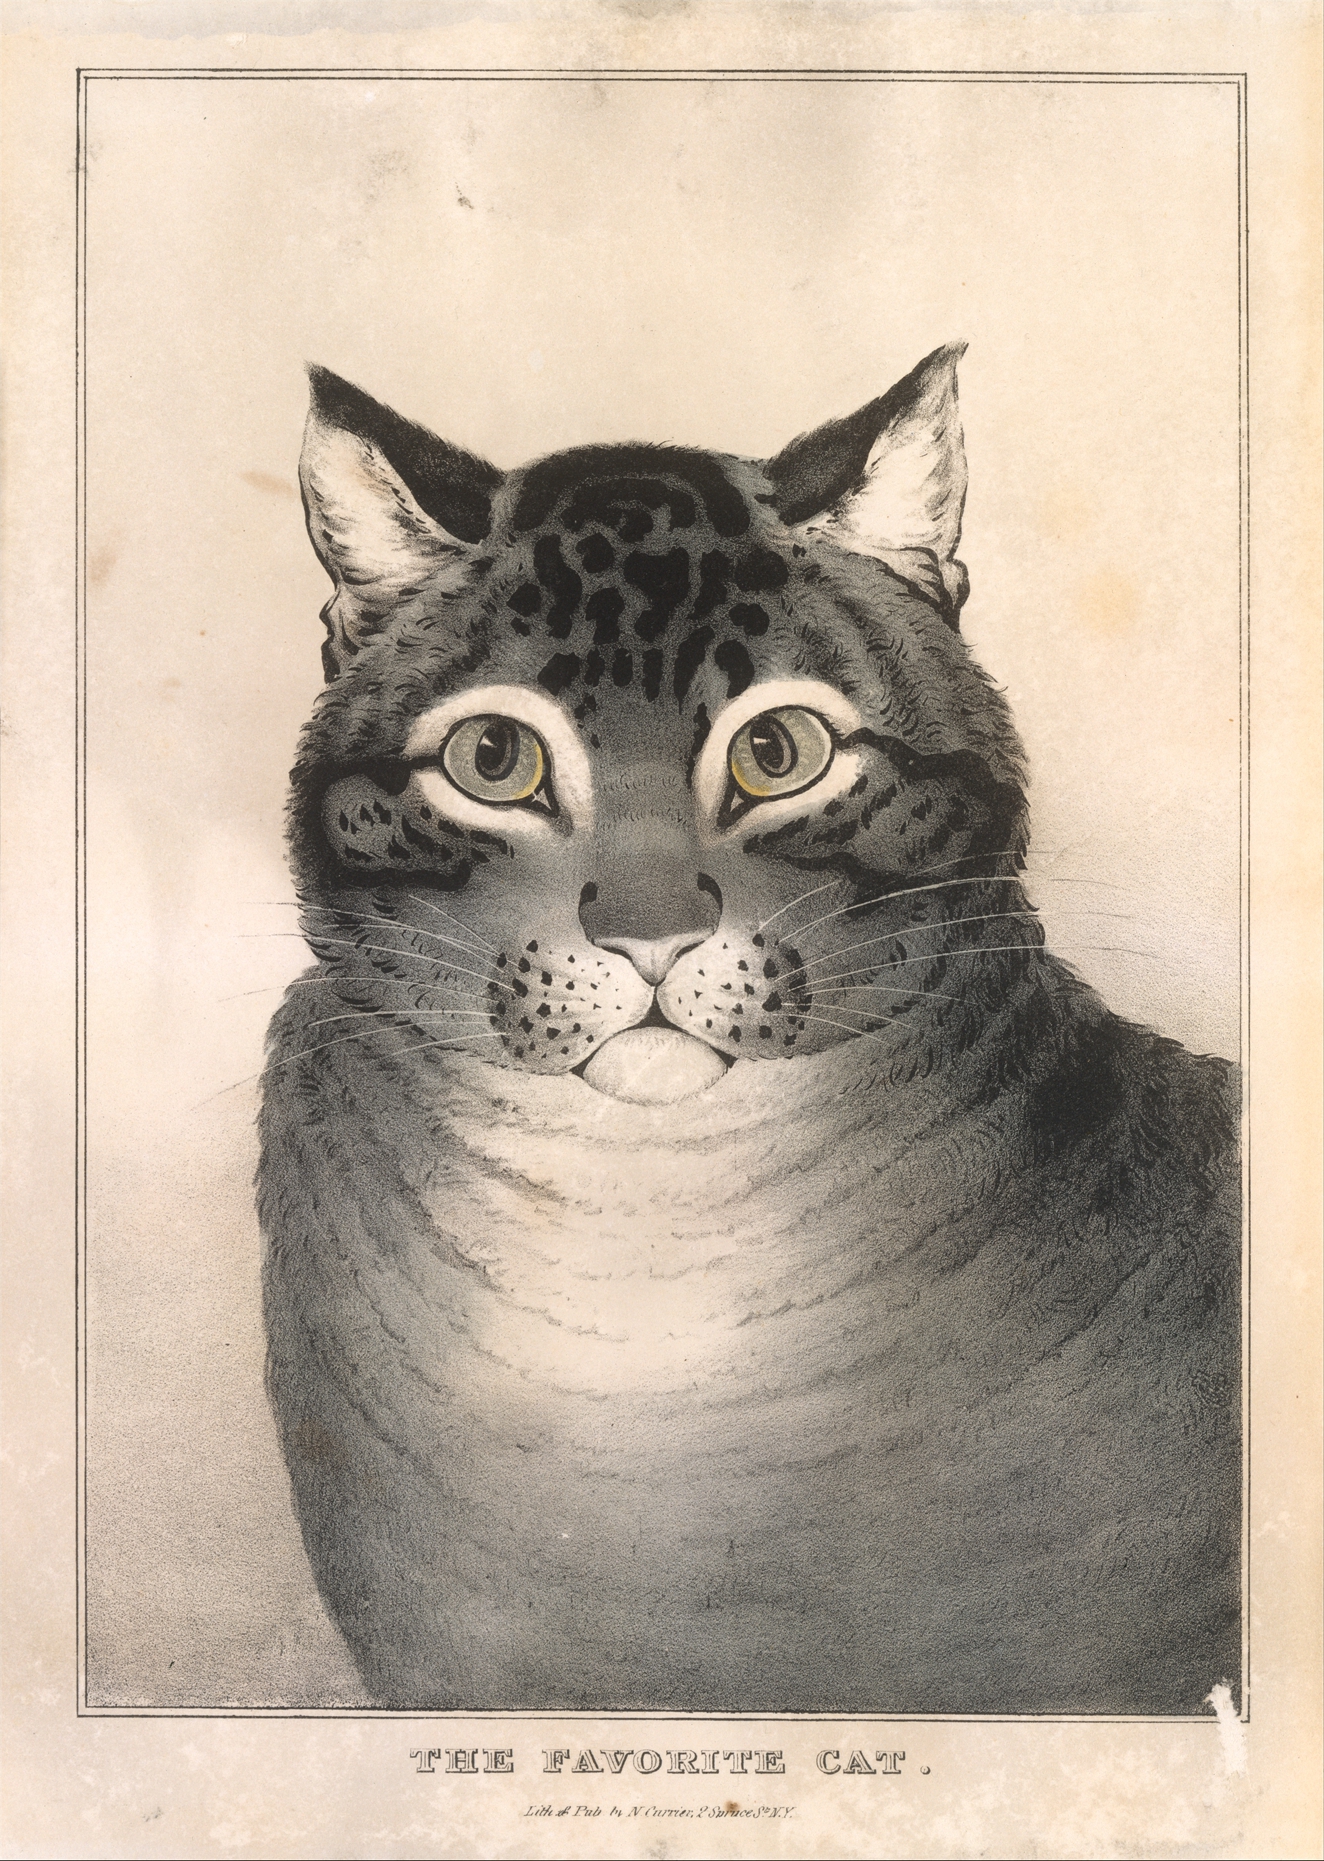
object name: print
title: The Favorite Cat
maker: nathaniel currier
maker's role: publisher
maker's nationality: american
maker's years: 1813-1888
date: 1838-1848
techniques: hand coloring, lithograph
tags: cats